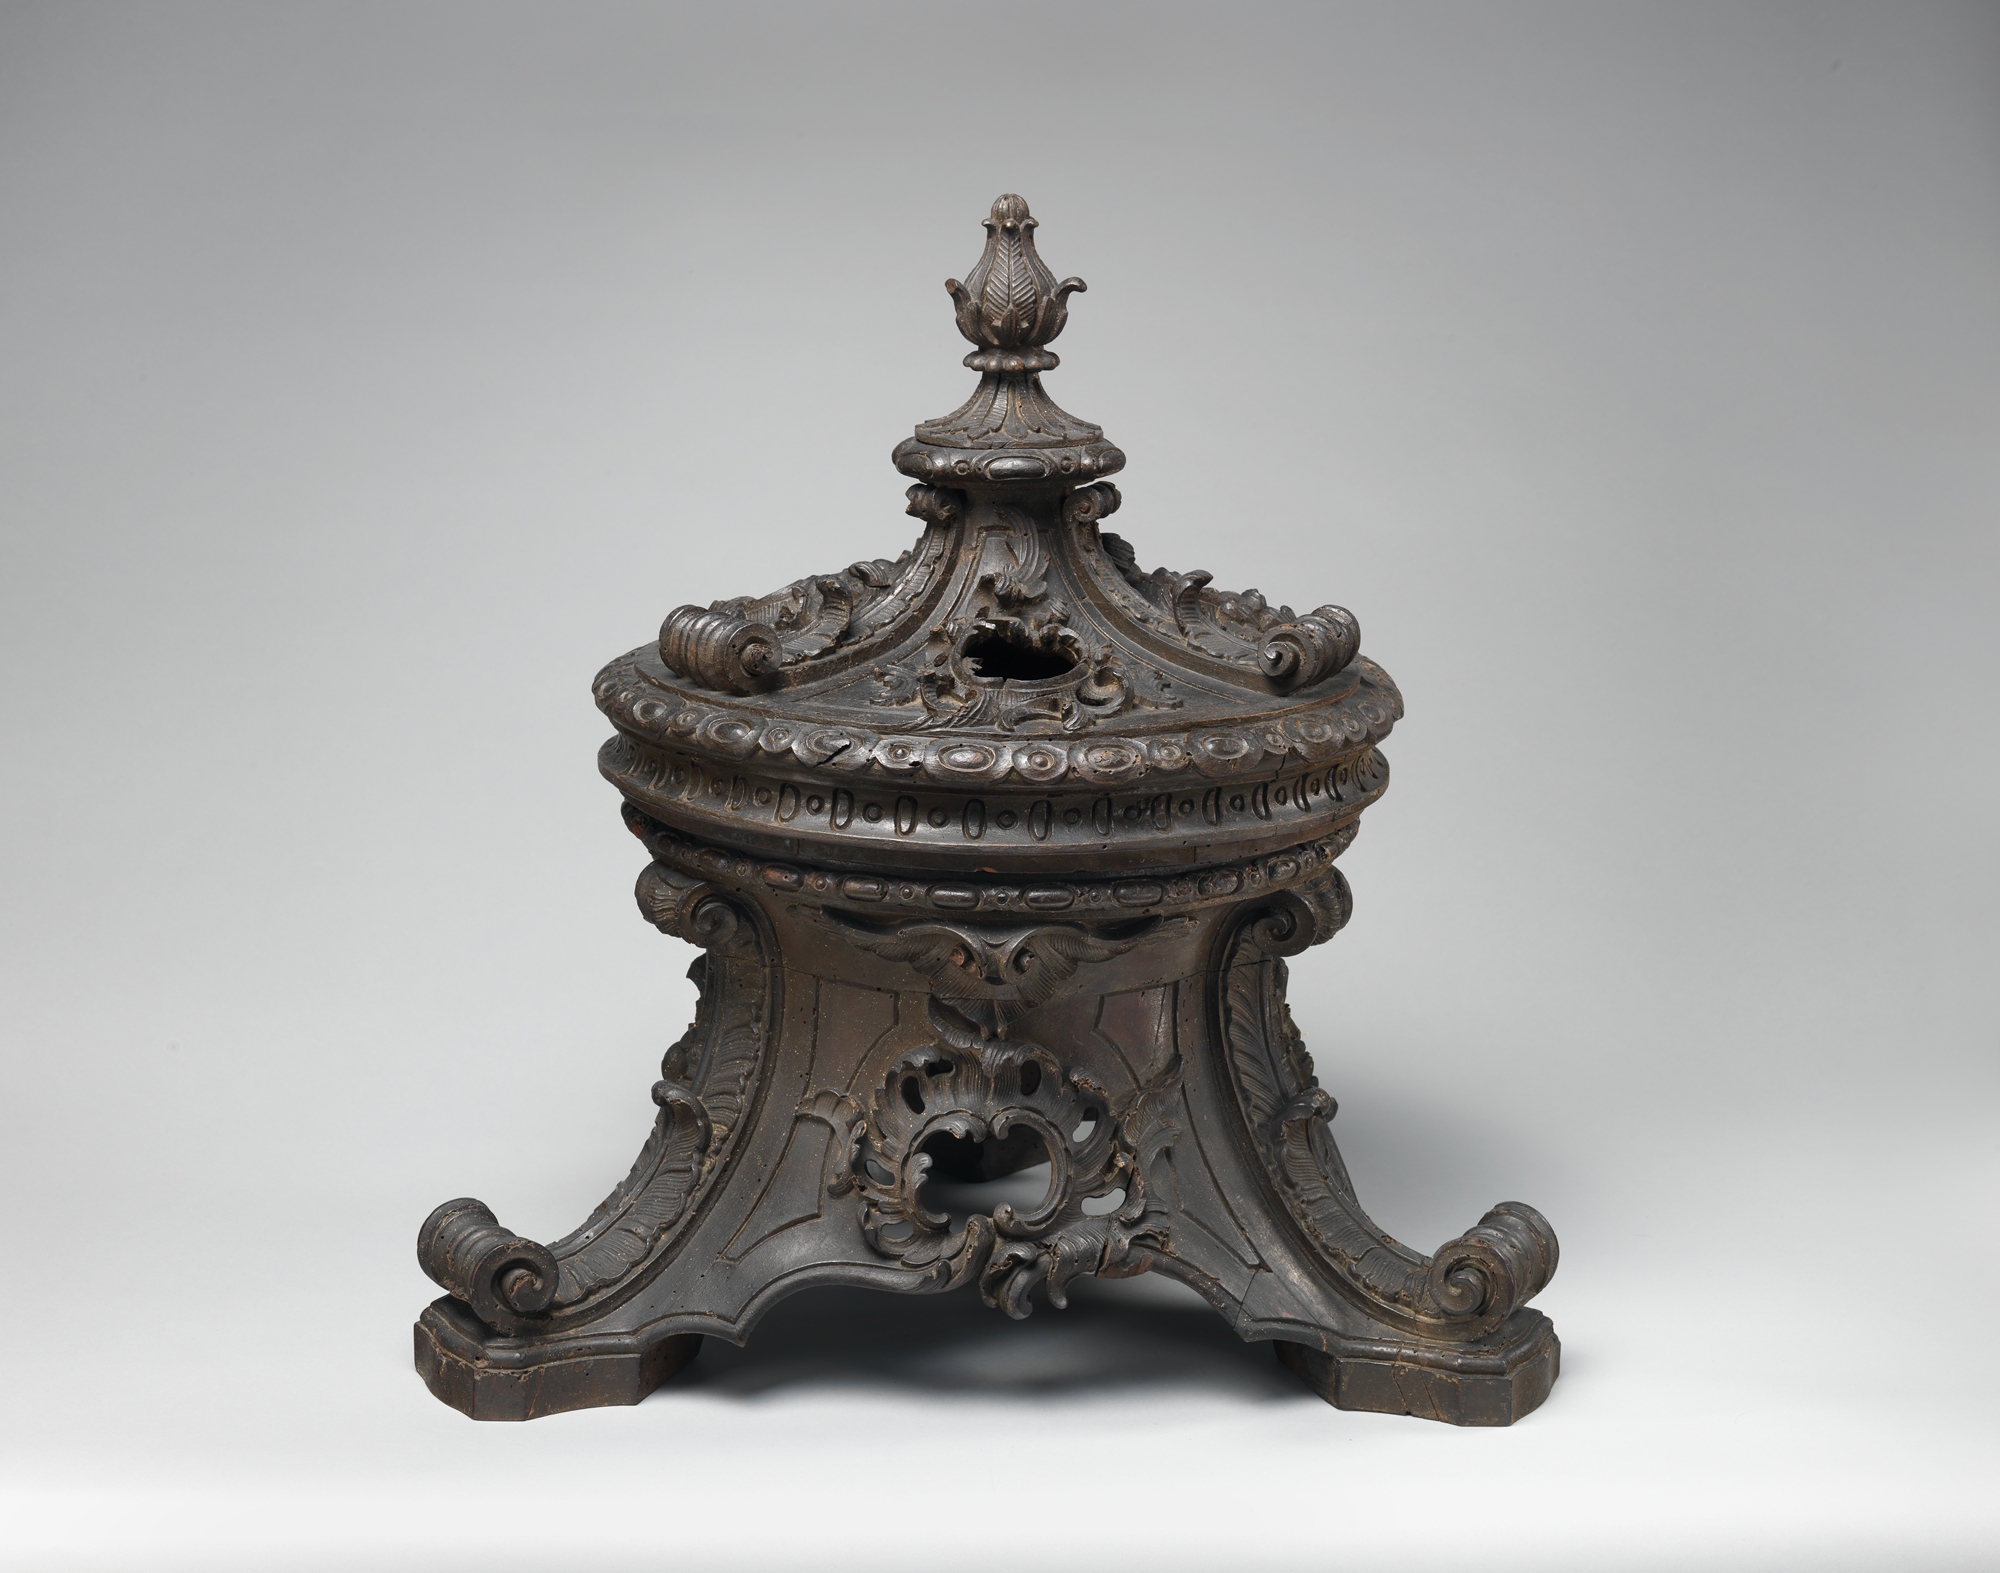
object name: brazier cover and base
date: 1701-1800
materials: wood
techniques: carving